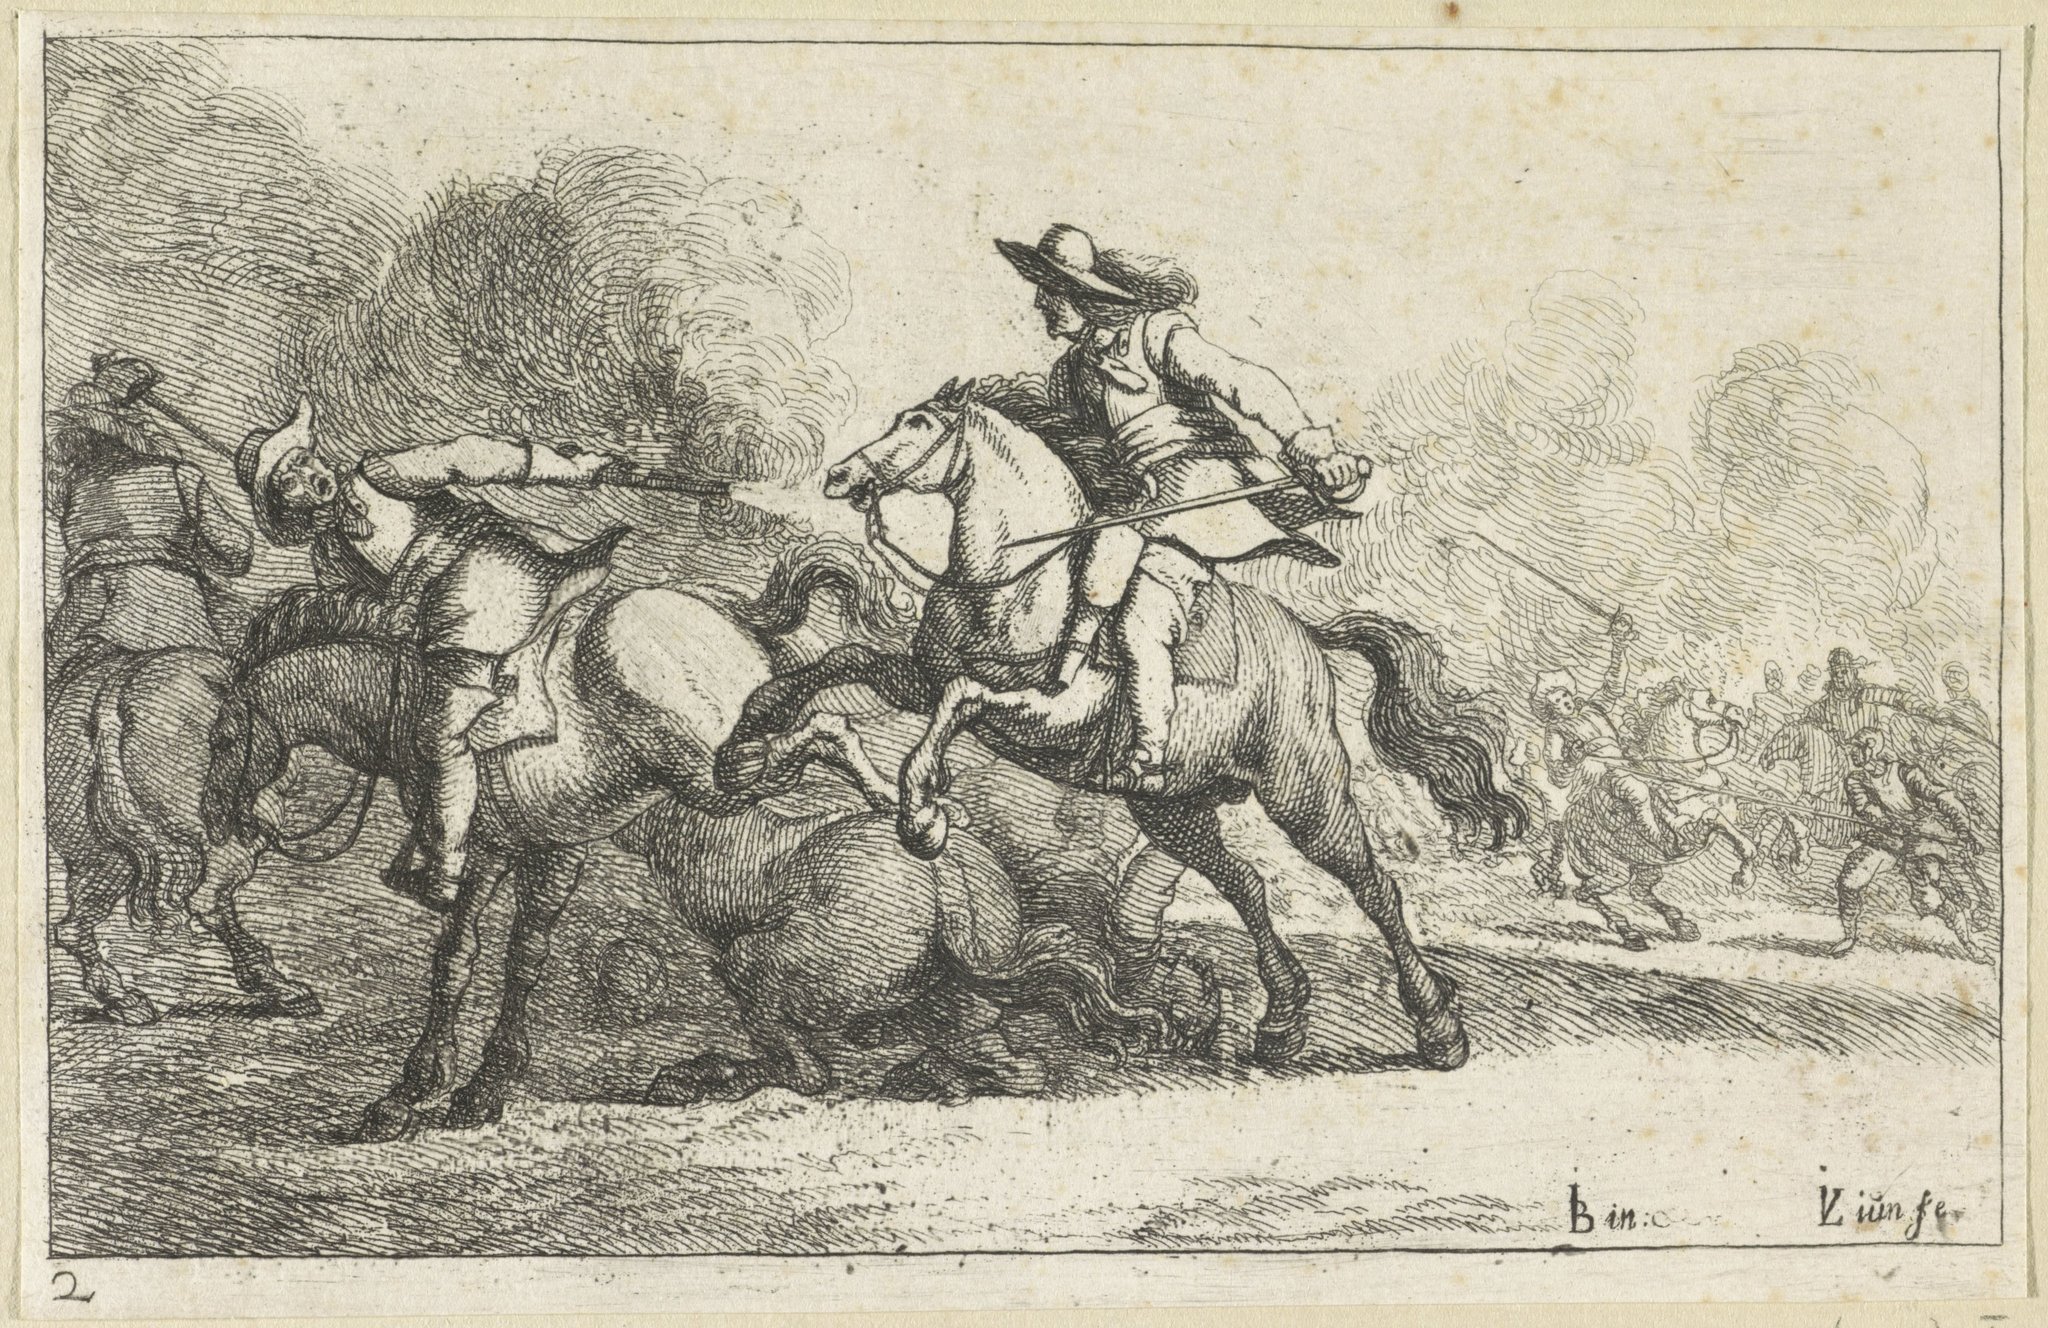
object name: print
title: Ruitergevechten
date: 1651-1652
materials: paper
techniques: etching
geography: antwerp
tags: battle (+ cavalry, horsemen), firearms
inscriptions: collector's mark: Lugt 240